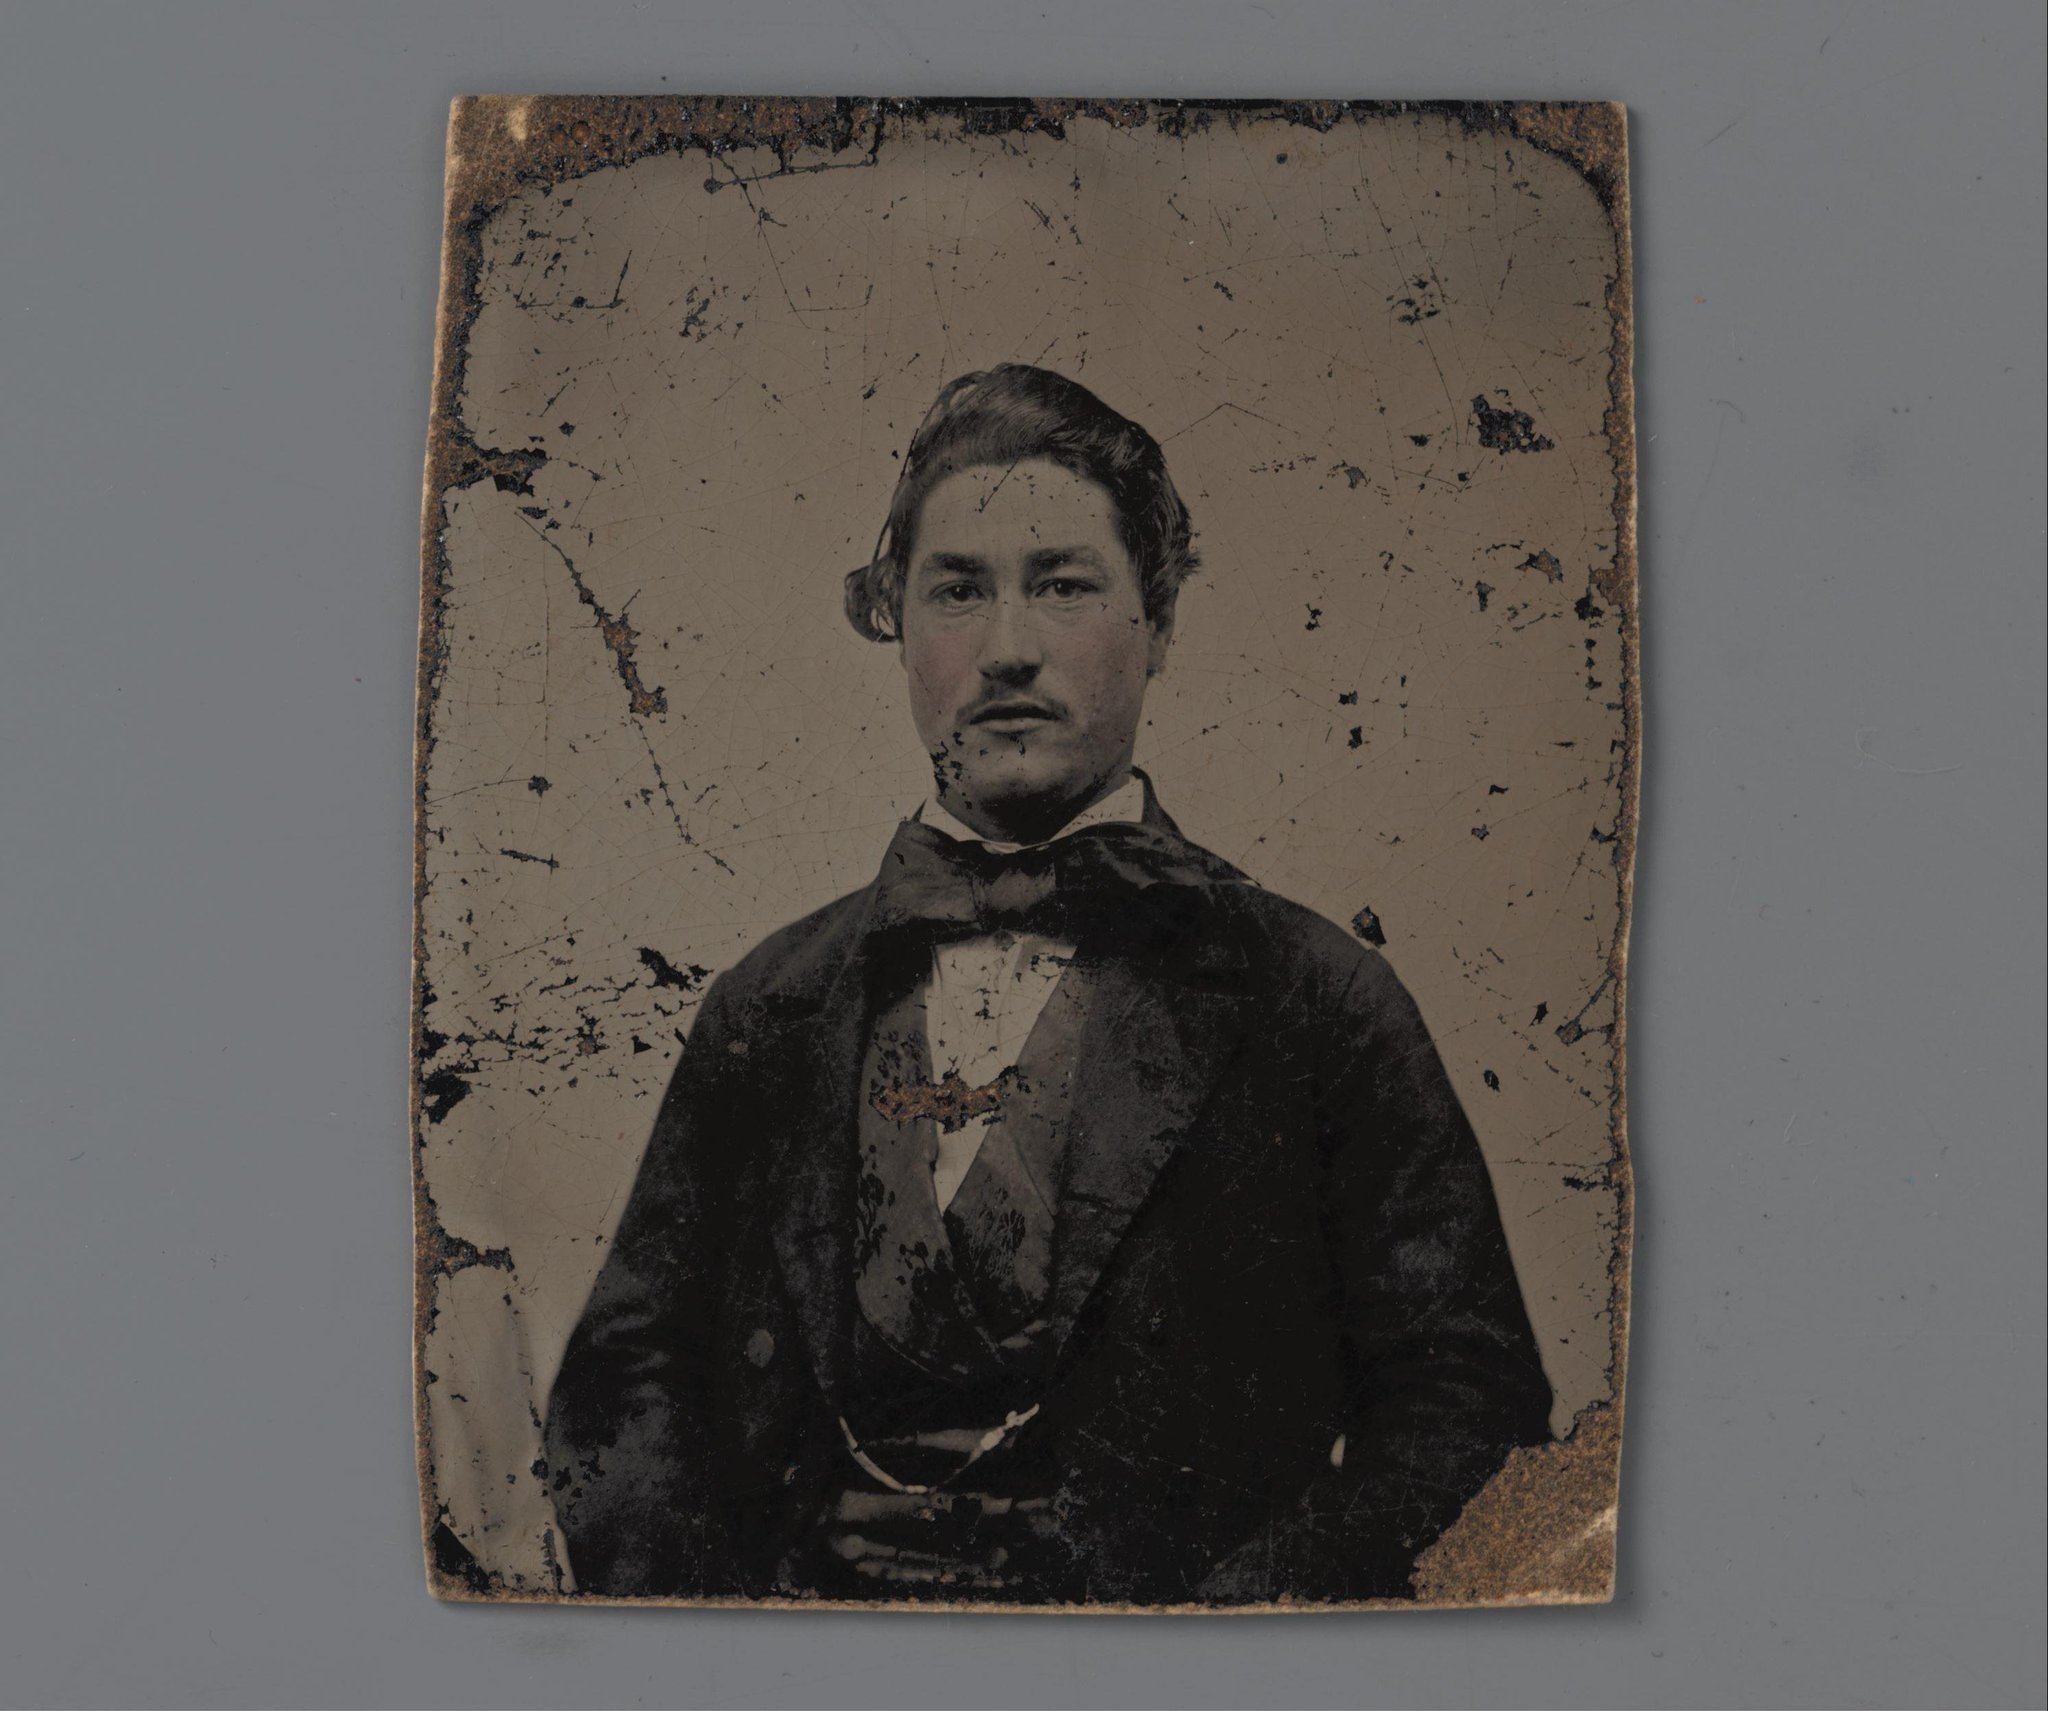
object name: photograph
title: Portret van een onbekende man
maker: Anonymous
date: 1853-1860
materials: cardboard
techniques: hand coloring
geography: united states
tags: anonymous historical person portrayed alone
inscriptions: inscription: ‘uit Rinhart, New York,/ Catalogus 5 herfst 1972/ no 450: cardboard base portrait/ Collodium print on pressed cardboard/ Handmade portrait of a man/ 2 1/4 x 3. 1850's. A most rare and/ unusual photographic technique./ good. $3,- (f12,-)’